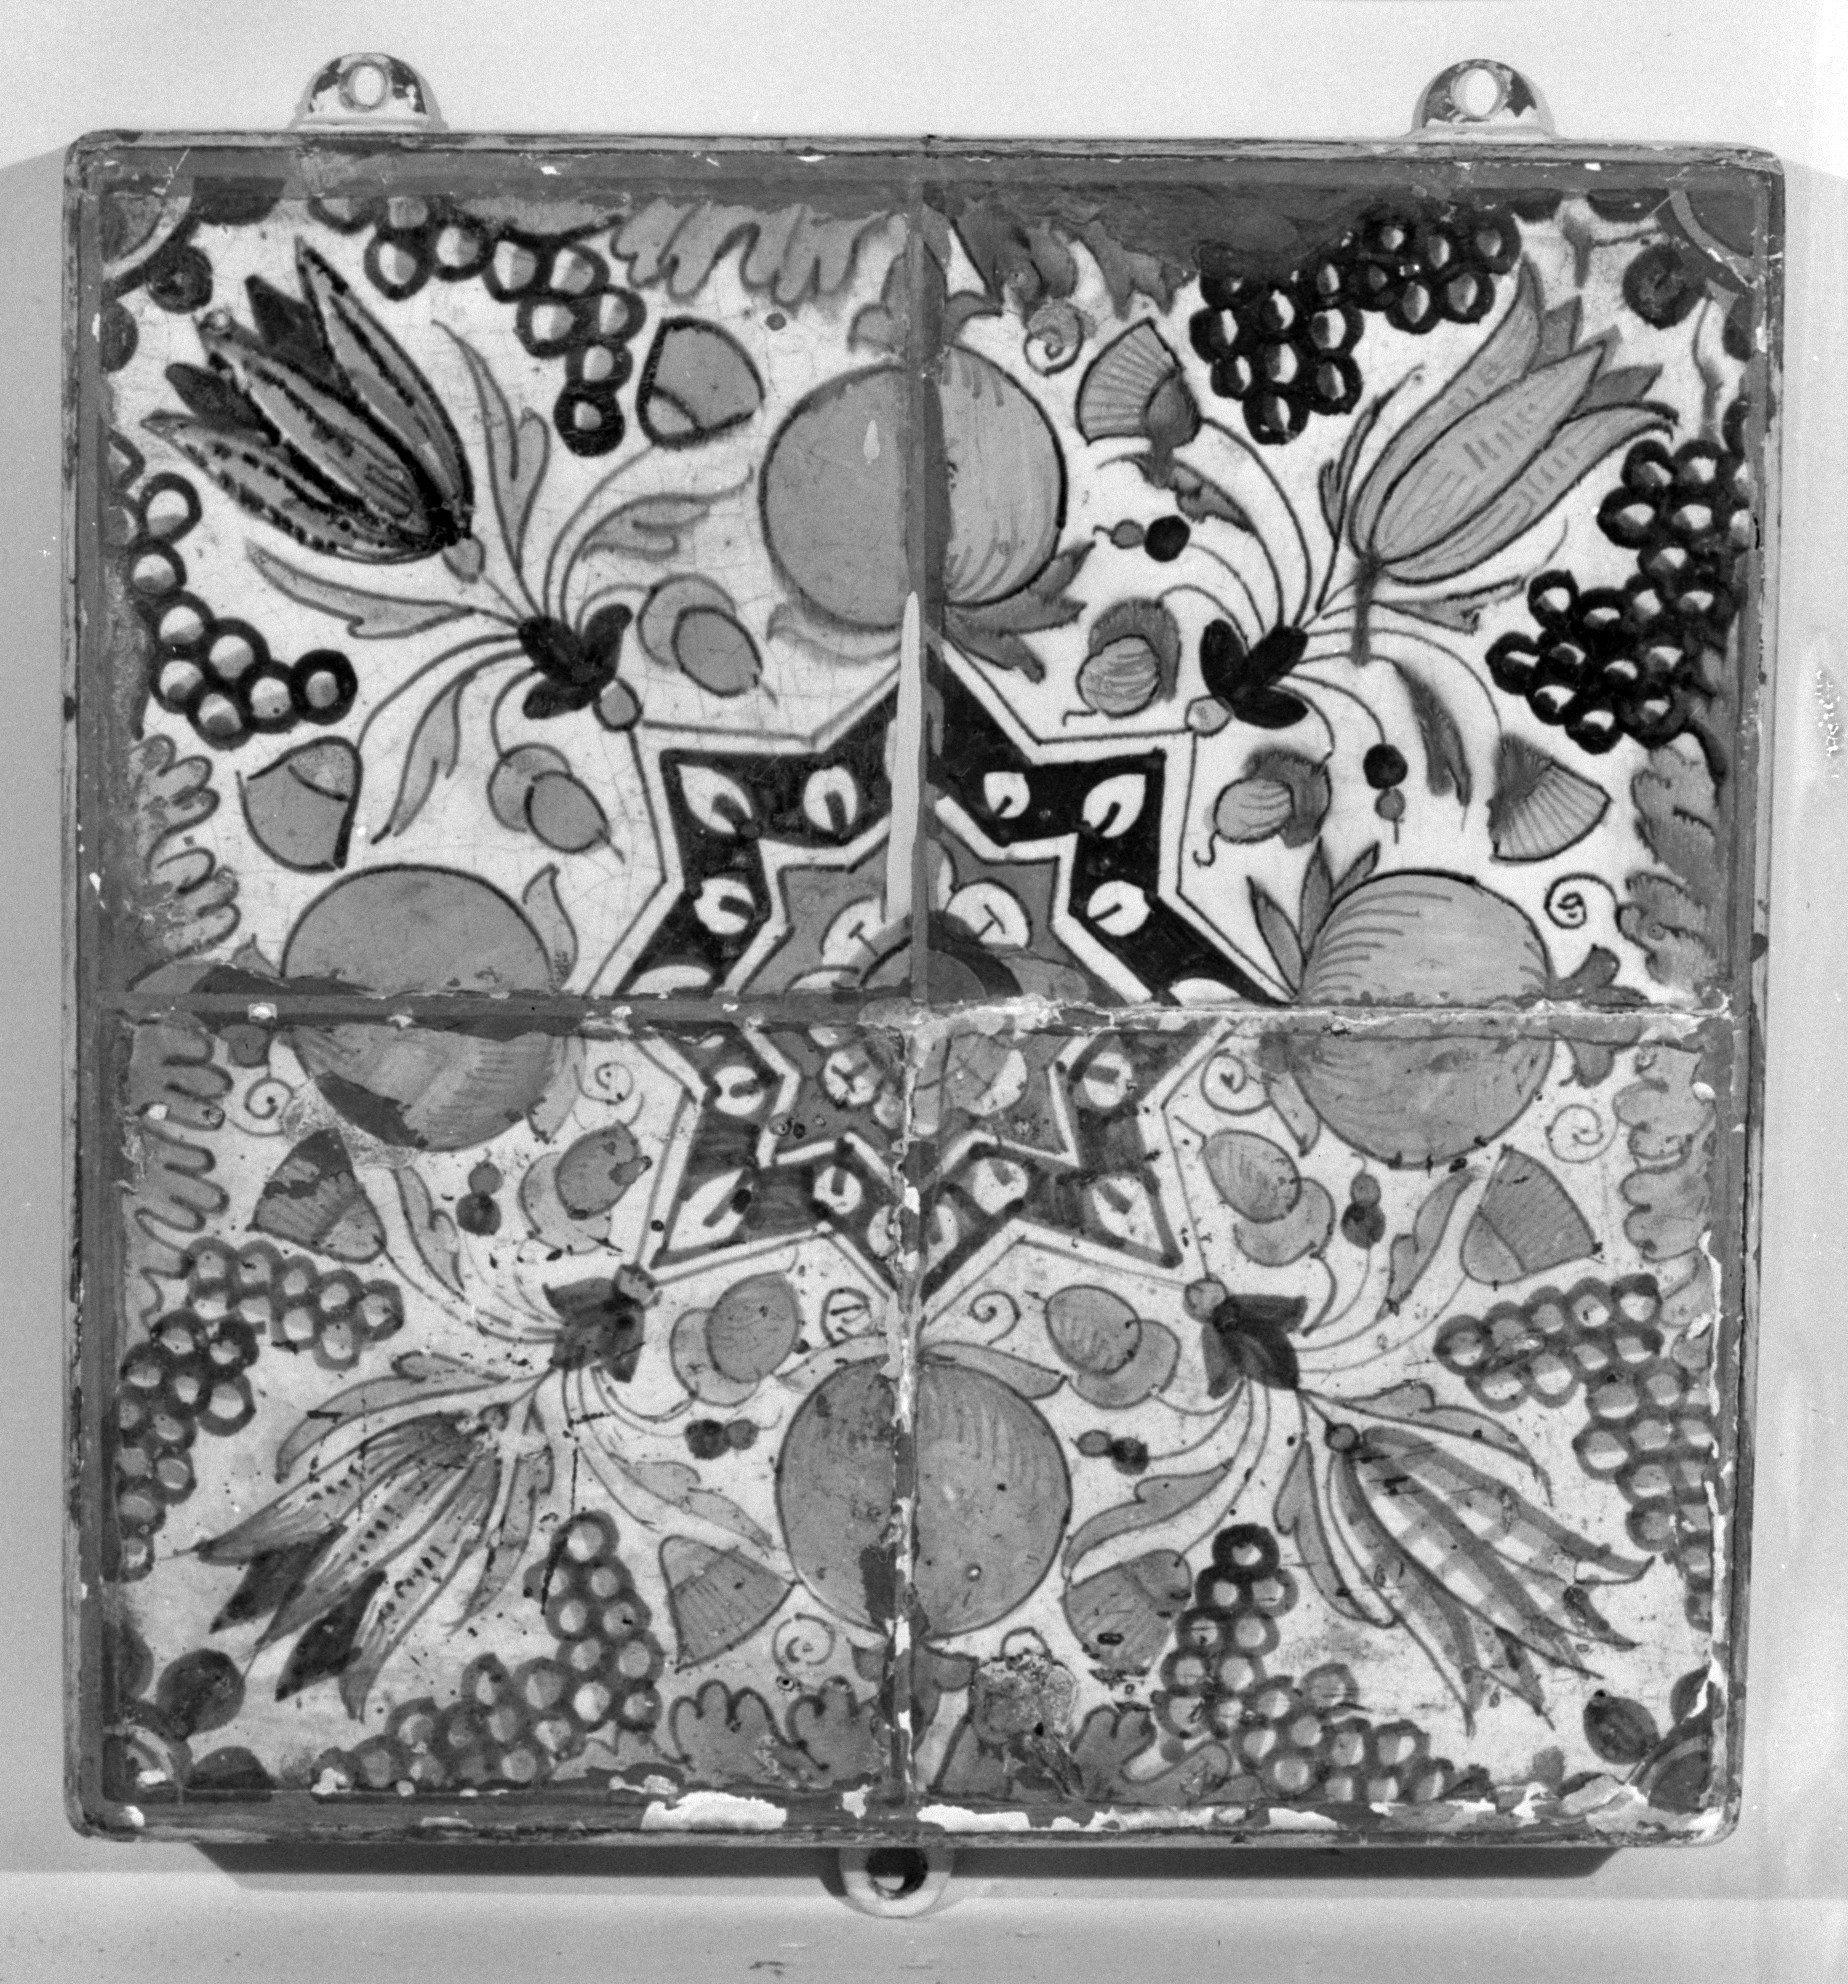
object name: tile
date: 1601-1625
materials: earthenware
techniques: glazing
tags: fruit,grapes,flowers